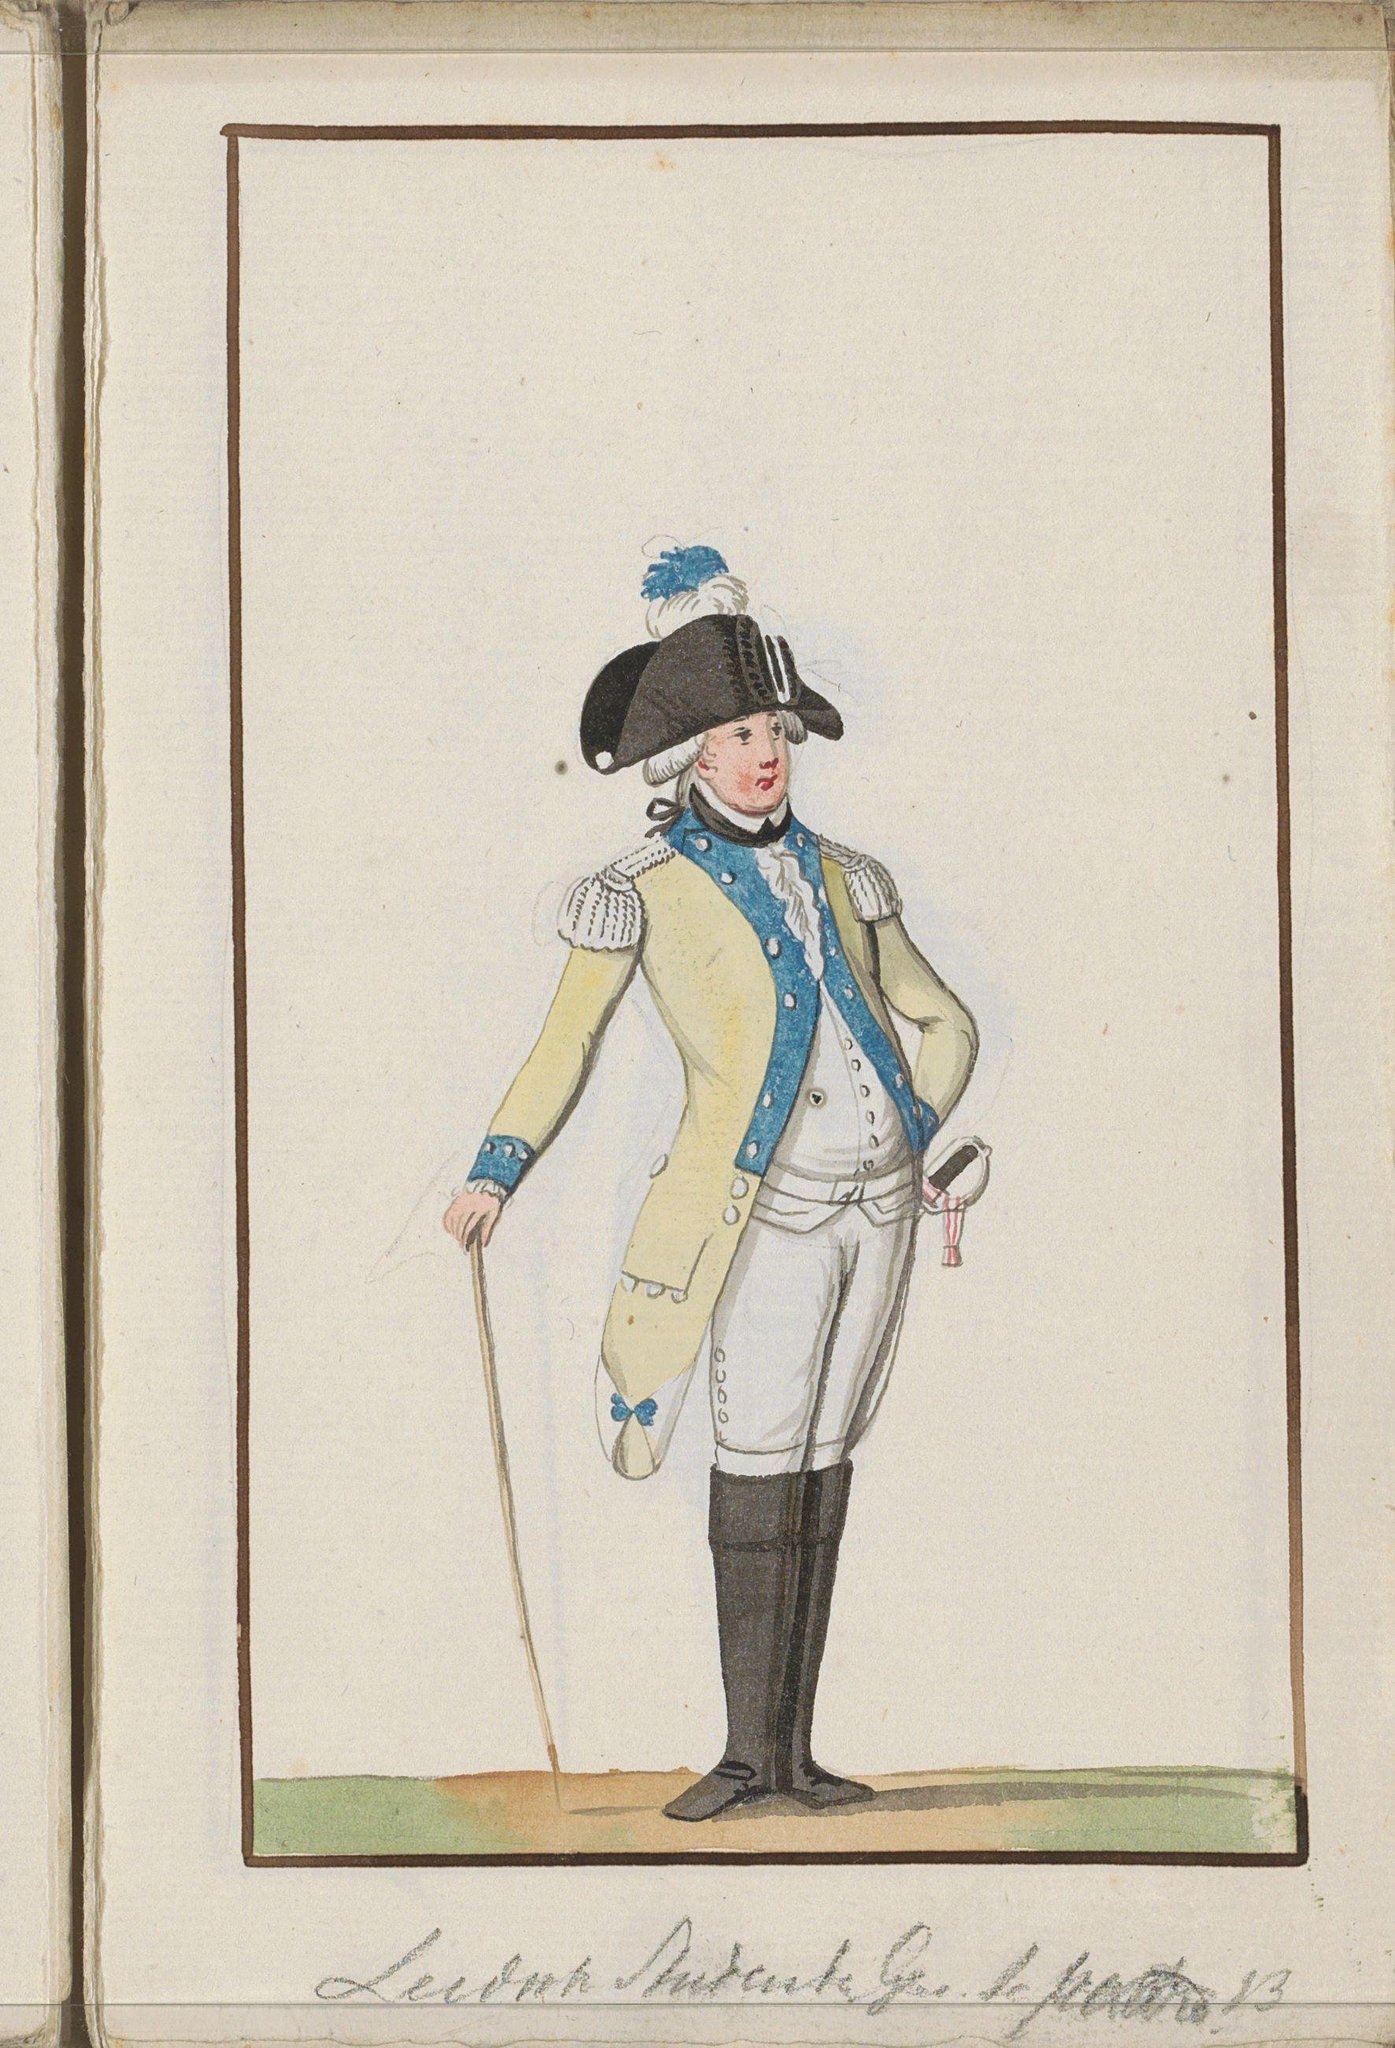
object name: drawing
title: Montering van de cavalerie van het exercitiegenootschap van Leidse studenten, ca. 1785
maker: Anonymous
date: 1789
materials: paper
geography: northern netherlands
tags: (military) uniforms (+ citizen soldiery, civil guard, citizen militia), leiden, patriots (1780-1795)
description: Montering of uniform van de cavalerie van het exercitiegenootschap van Leidse studenten, ca. 1785. Onderdeel van een schetsboek met 41 gekleurde tekeningen van de monteringen van de gewapende schutterijen en burgercorpsen in Nederland in de periode ca. 1783-1789.